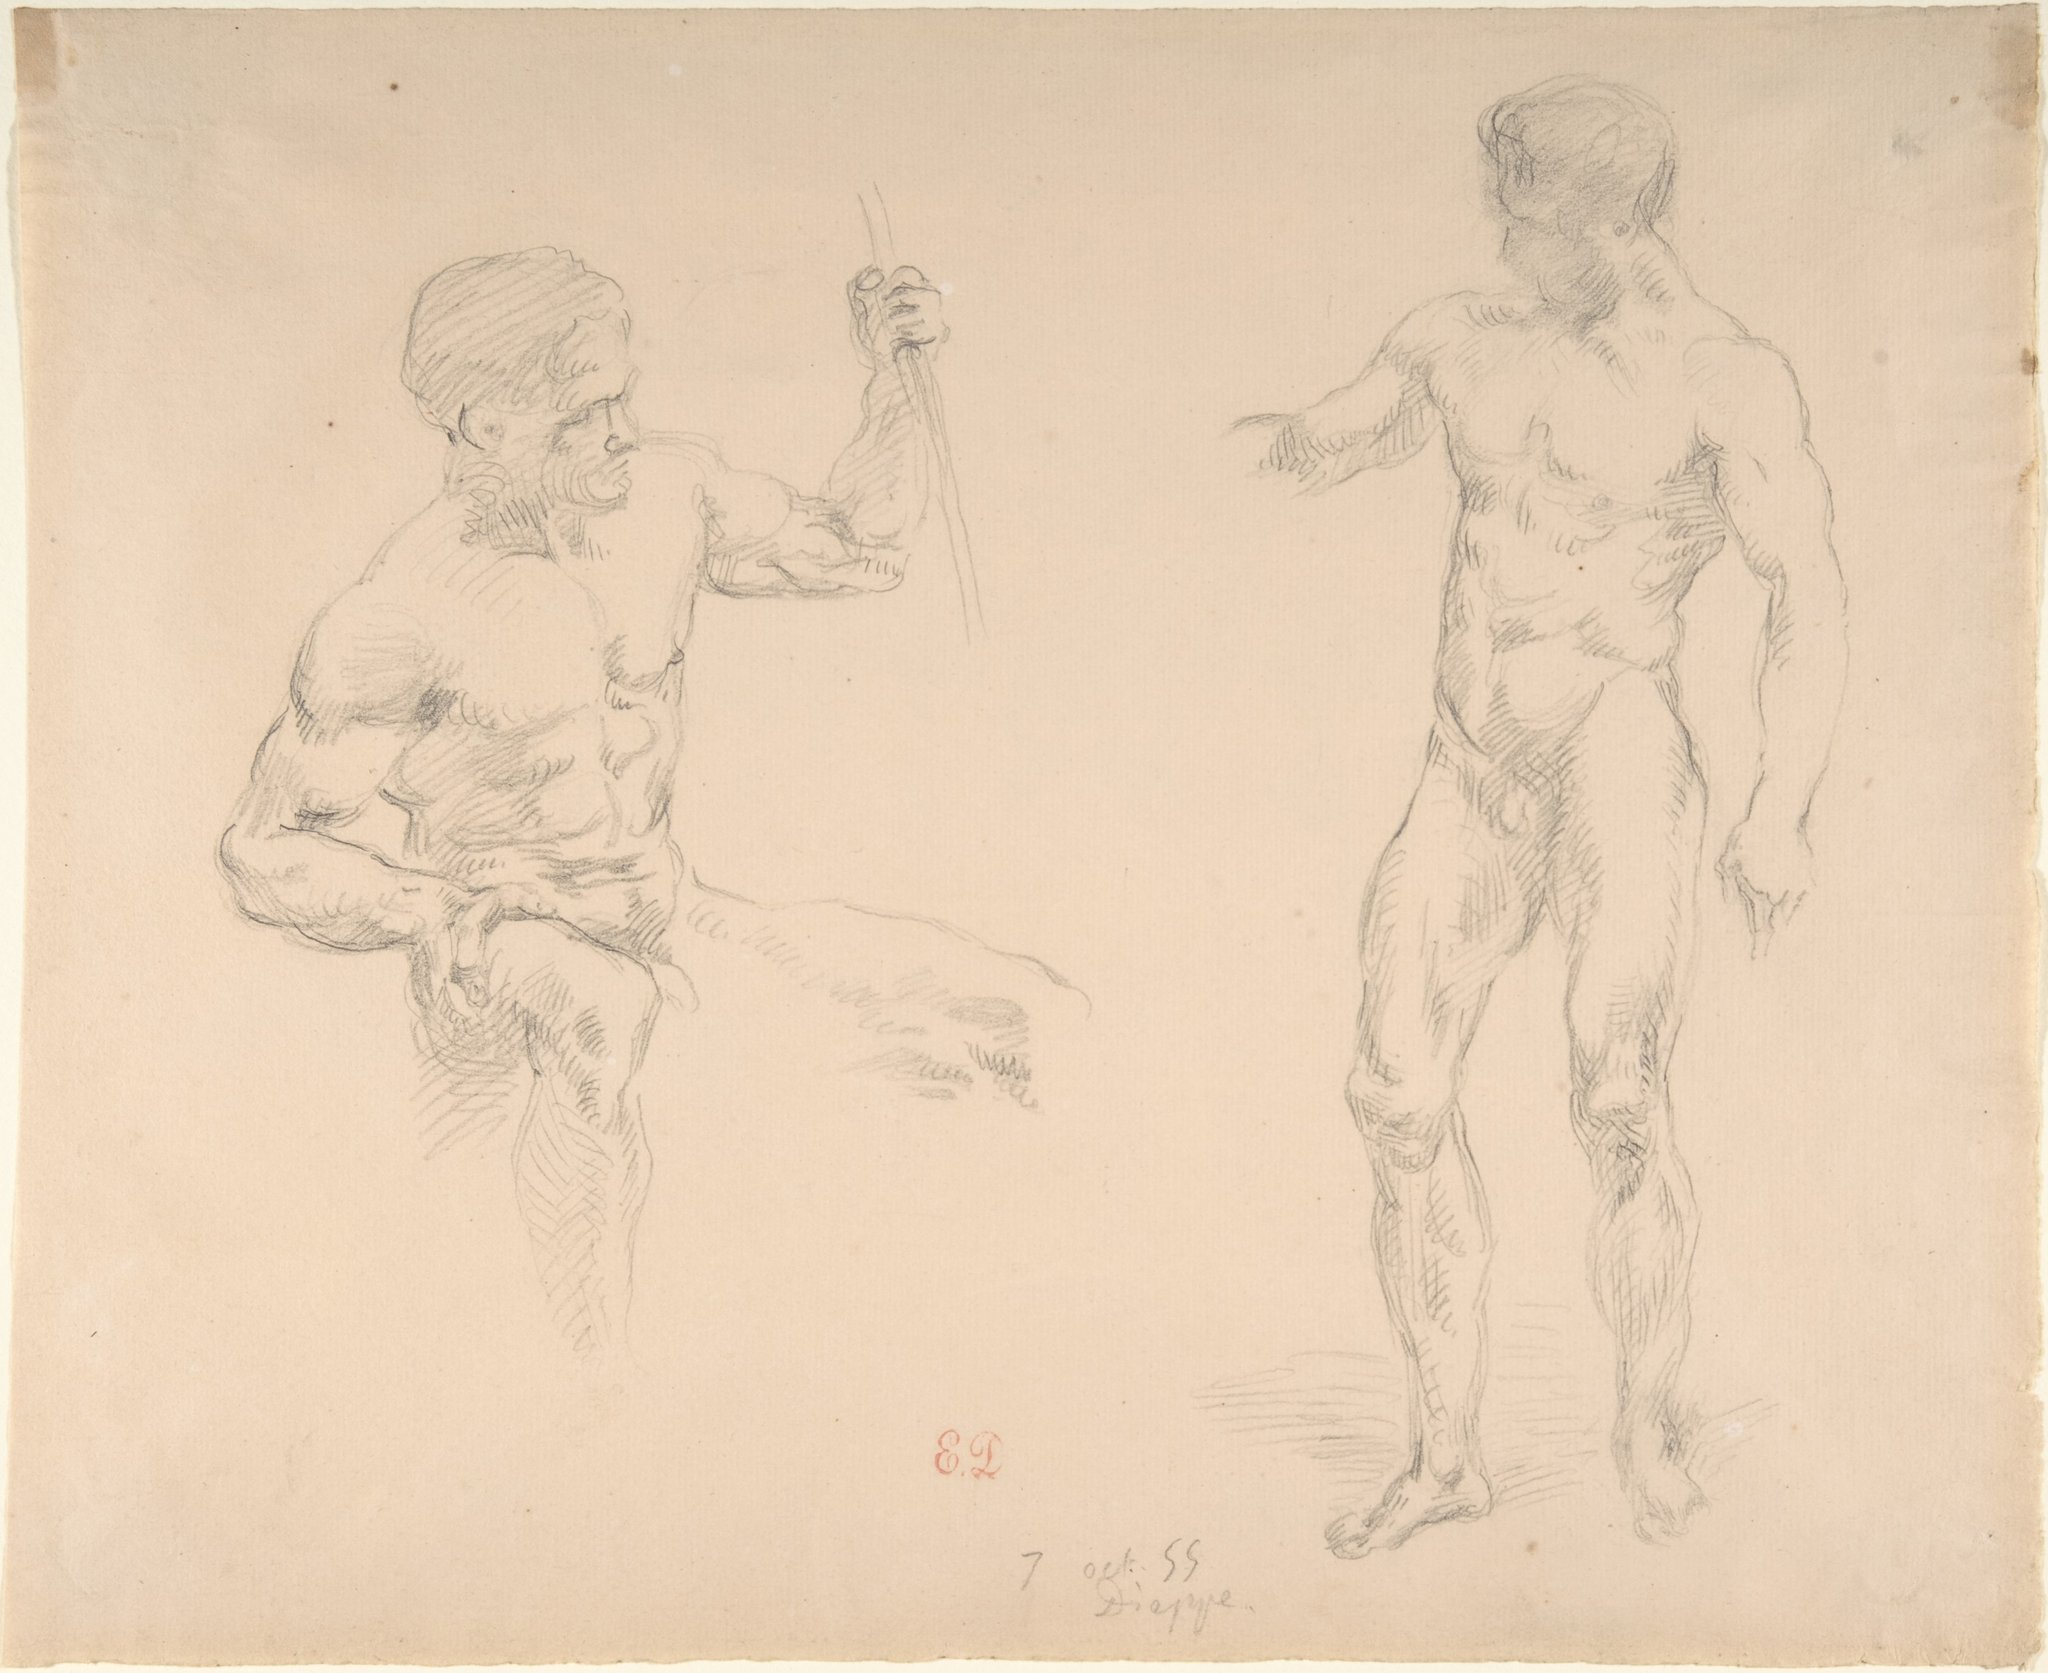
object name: drawing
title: Seated and Standing Male Nudes, after photographs by Eugène Durieu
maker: eugène delacroix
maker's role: artist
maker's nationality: french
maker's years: 1798-1863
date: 1855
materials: graphite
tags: male nudes